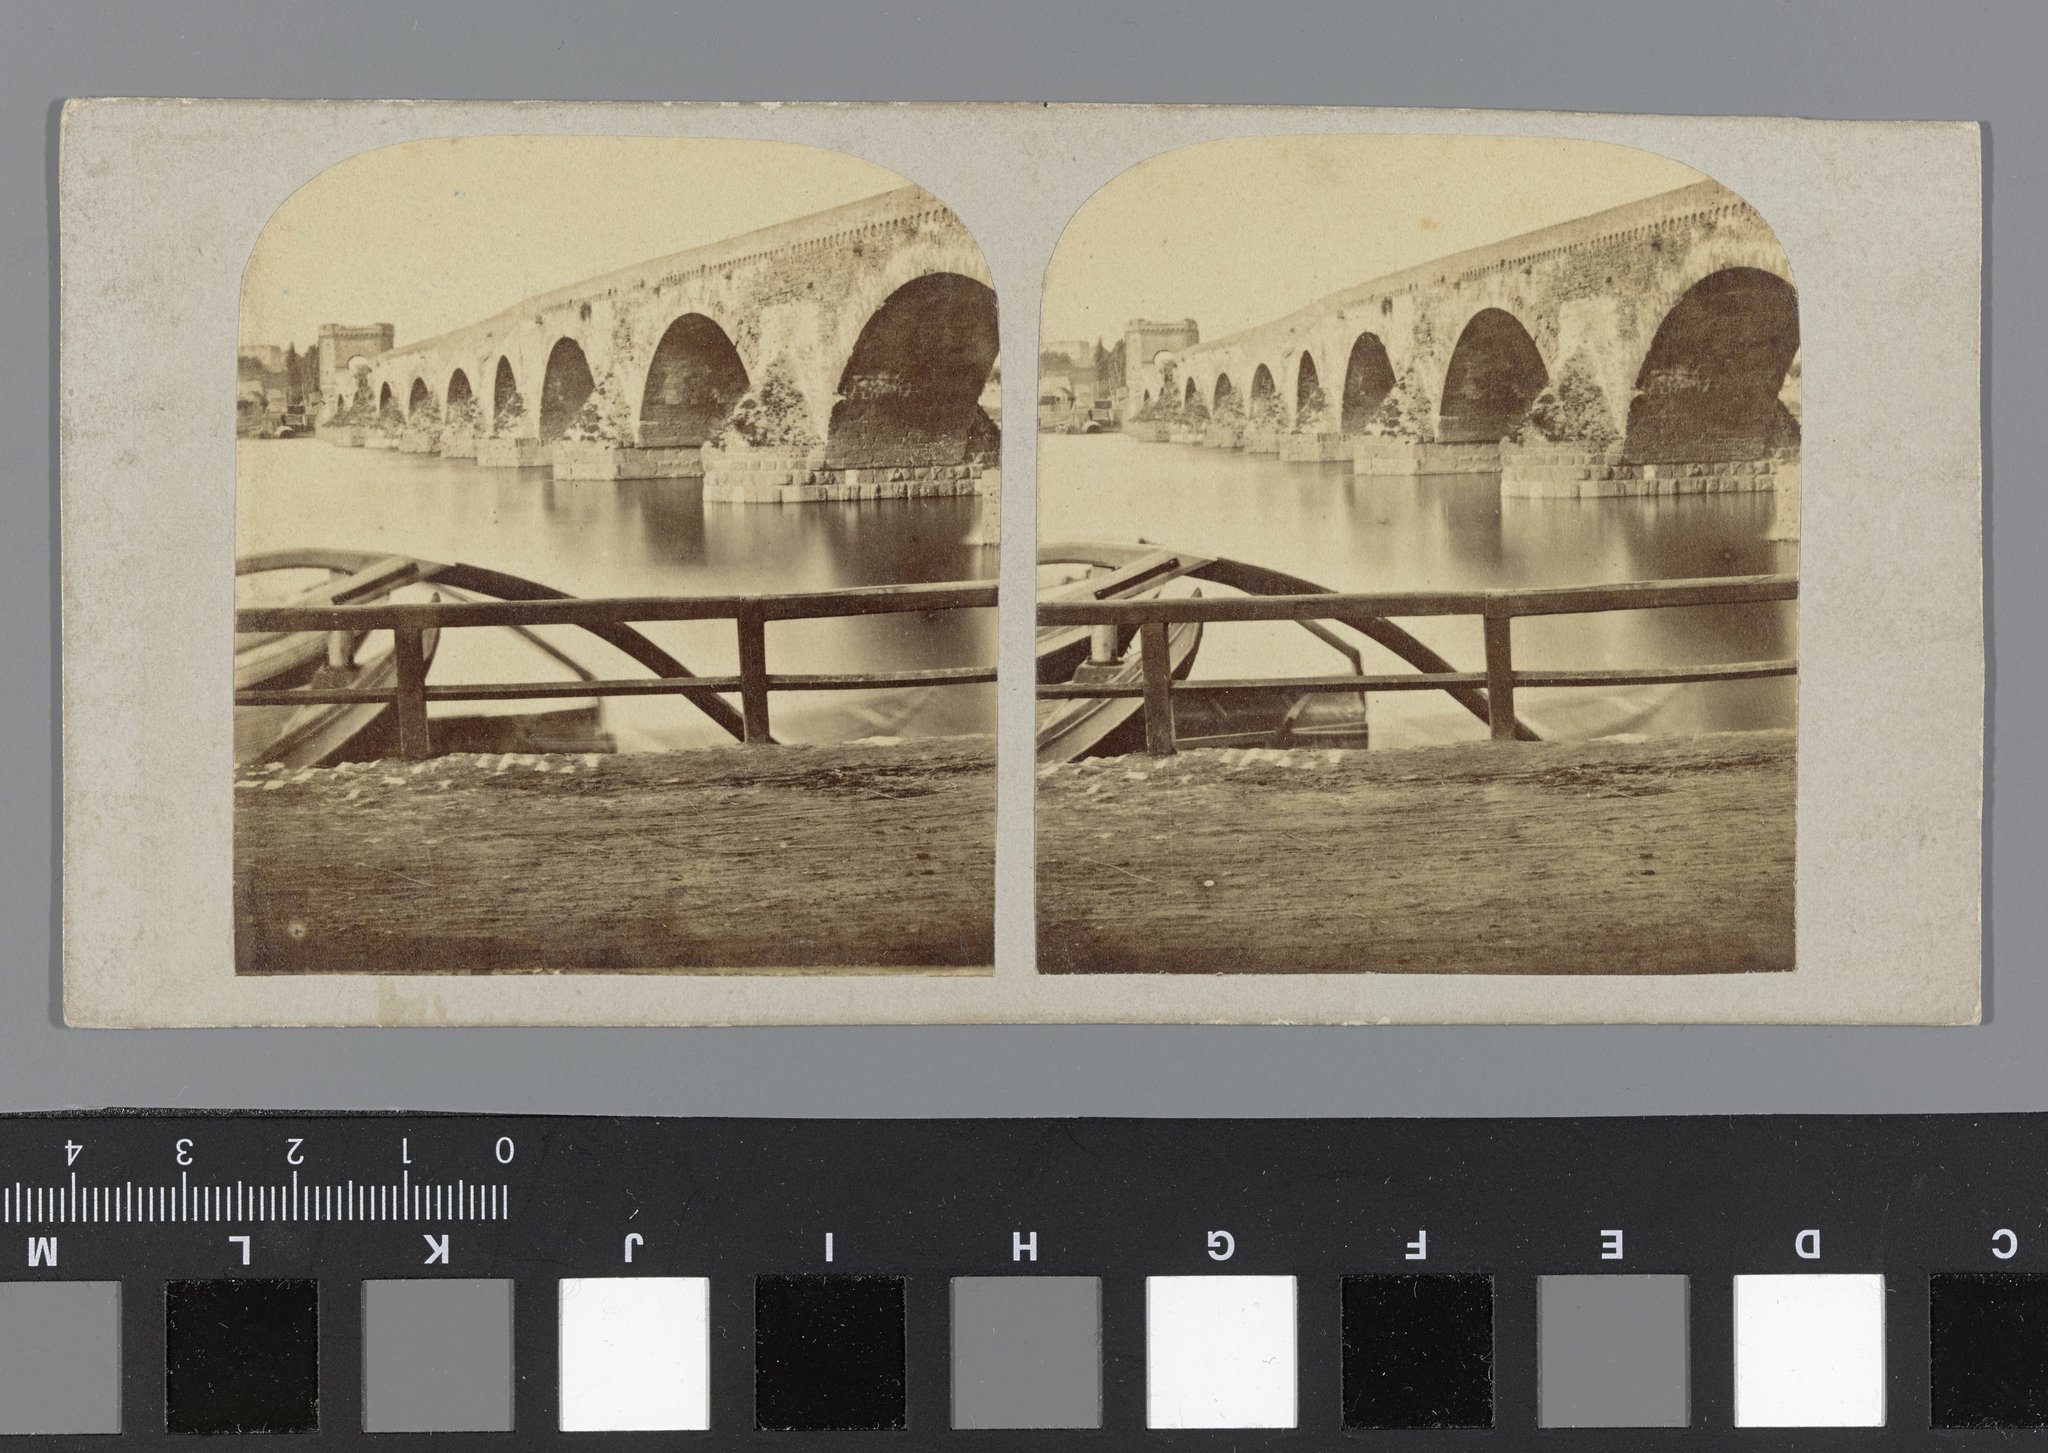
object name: photograph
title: Pont de la Moselle à Coblentz (14)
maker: Anonymous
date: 1855-1865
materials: cardboard, paper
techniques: albumen print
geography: koblenz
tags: landscape with bridge, viaduct or aqueduct, bridge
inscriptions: title: ‘Pont de la Moselle à Coblentz 14’